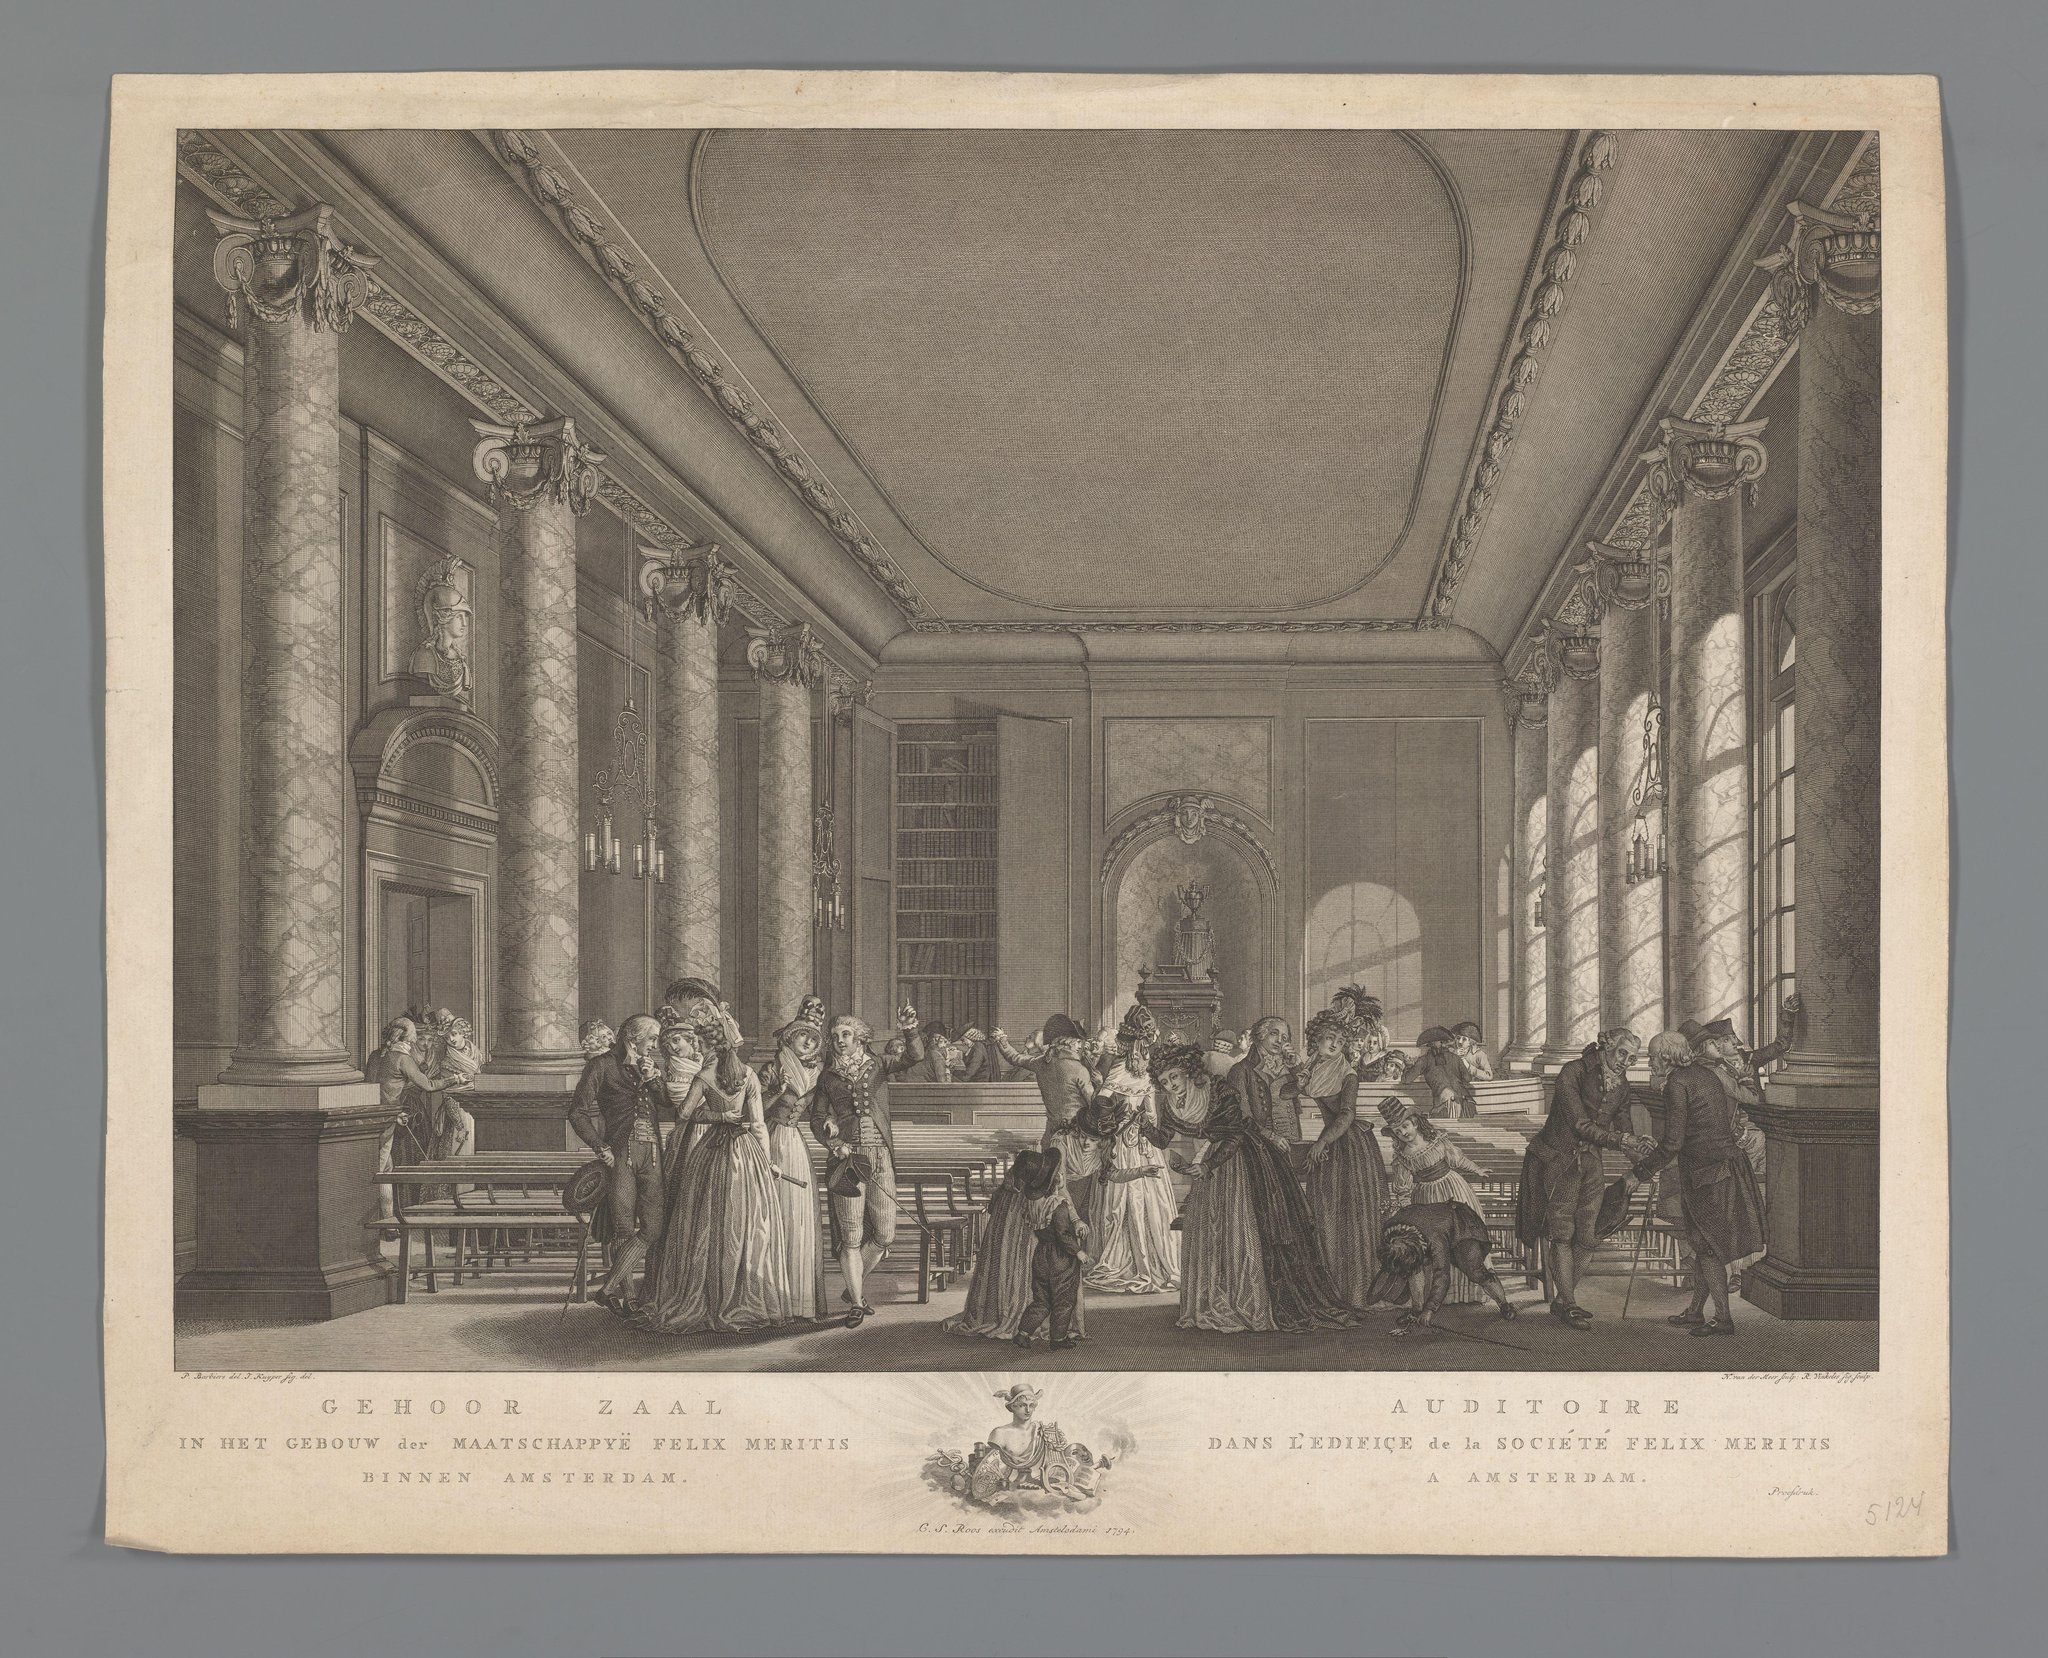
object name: print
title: Gehoor Zaal in het Gebouw der Maatschappyë Felix Meritis binnen Amsterdam / Auditoire dans l'Edifiçe de la Société Felix Meritis a Amsterdam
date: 1794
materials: paper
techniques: engraving, etching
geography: amsterdam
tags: learned society, academy of sciences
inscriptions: collector's mark: Lugt 2233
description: Bezoekers in de Gehoorzaal in het gebouw van de maatschappij Felix Meritis te Amsterdam, ingewijd in 1789.